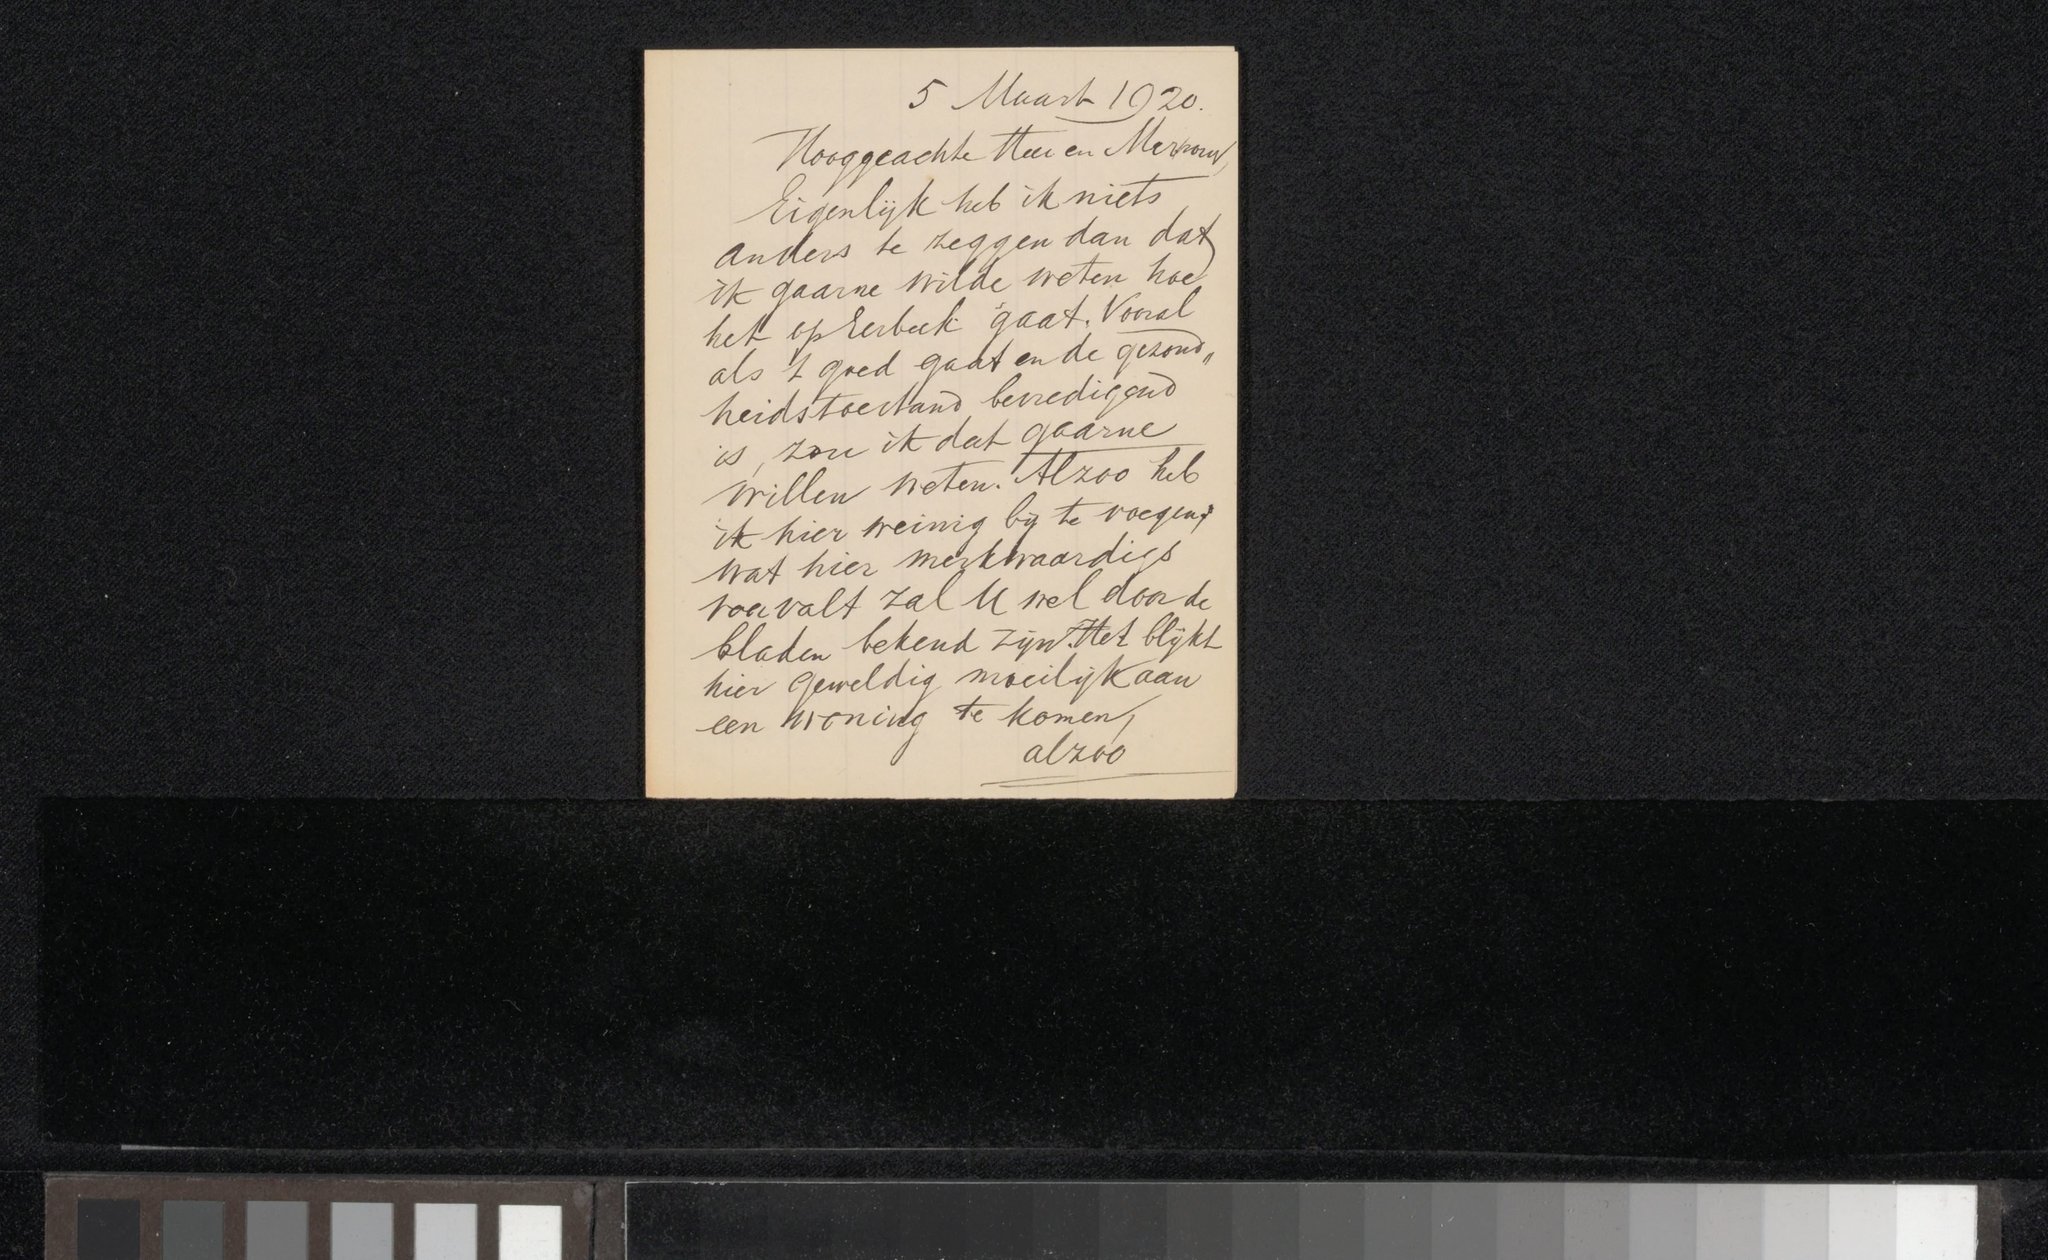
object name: letter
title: Brief aan Max Wilhelm Carl Weber en Anne Antoinette Weber-Van Bosse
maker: august allebé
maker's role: draughtsman, print maker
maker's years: 1838-1927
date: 1920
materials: ink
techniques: pen, writing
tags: anne antoinette weber-van bosse, amsterdam, print maker, draughtsman, johan braakensiek, multatuli, travelling; tourism, illustration ~ printed matter, book, diseases, france